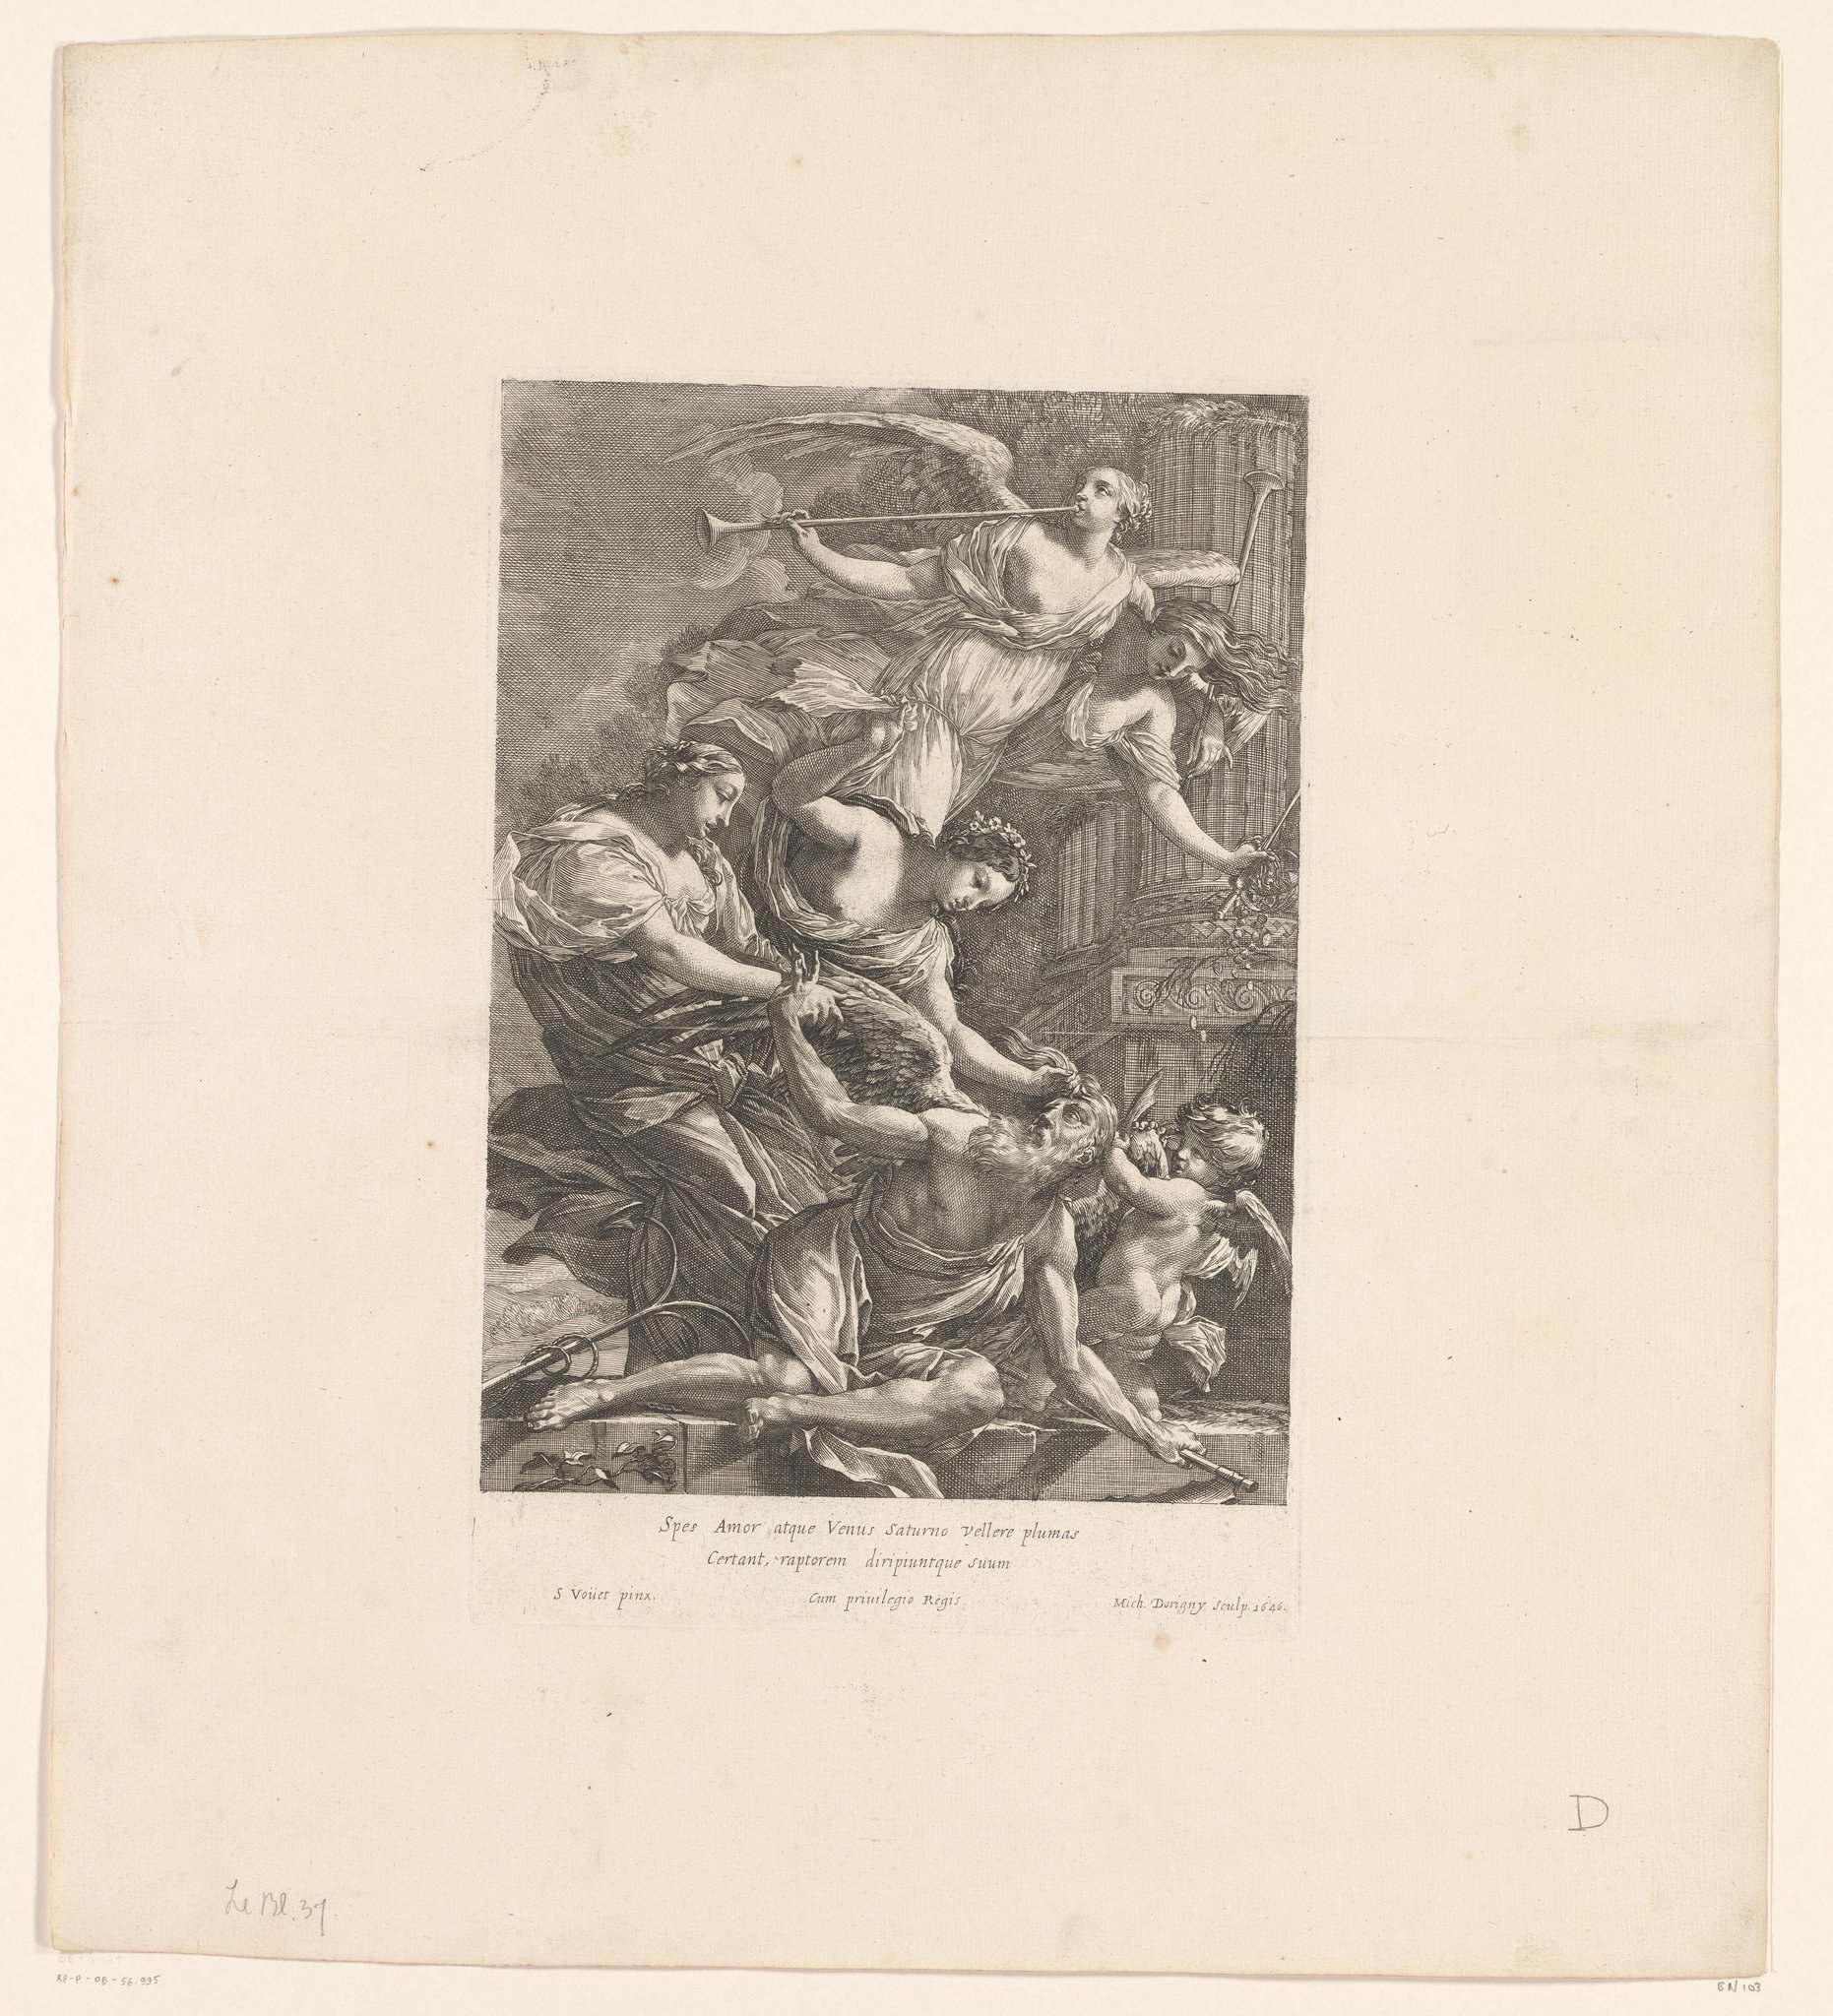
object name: print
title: Tijd overwonnen door Hoop, Amor en Venus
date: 1646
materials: paper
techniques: engraving, etching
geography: france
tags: hope; 'speranza', 'speranza delle fatiche' (ripa), (story of) venus (aphrodite), cupids: 'amores', 'amoretti', 'putti', father time, man with wings and scythe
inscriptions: collector's mark: Lugt 2228